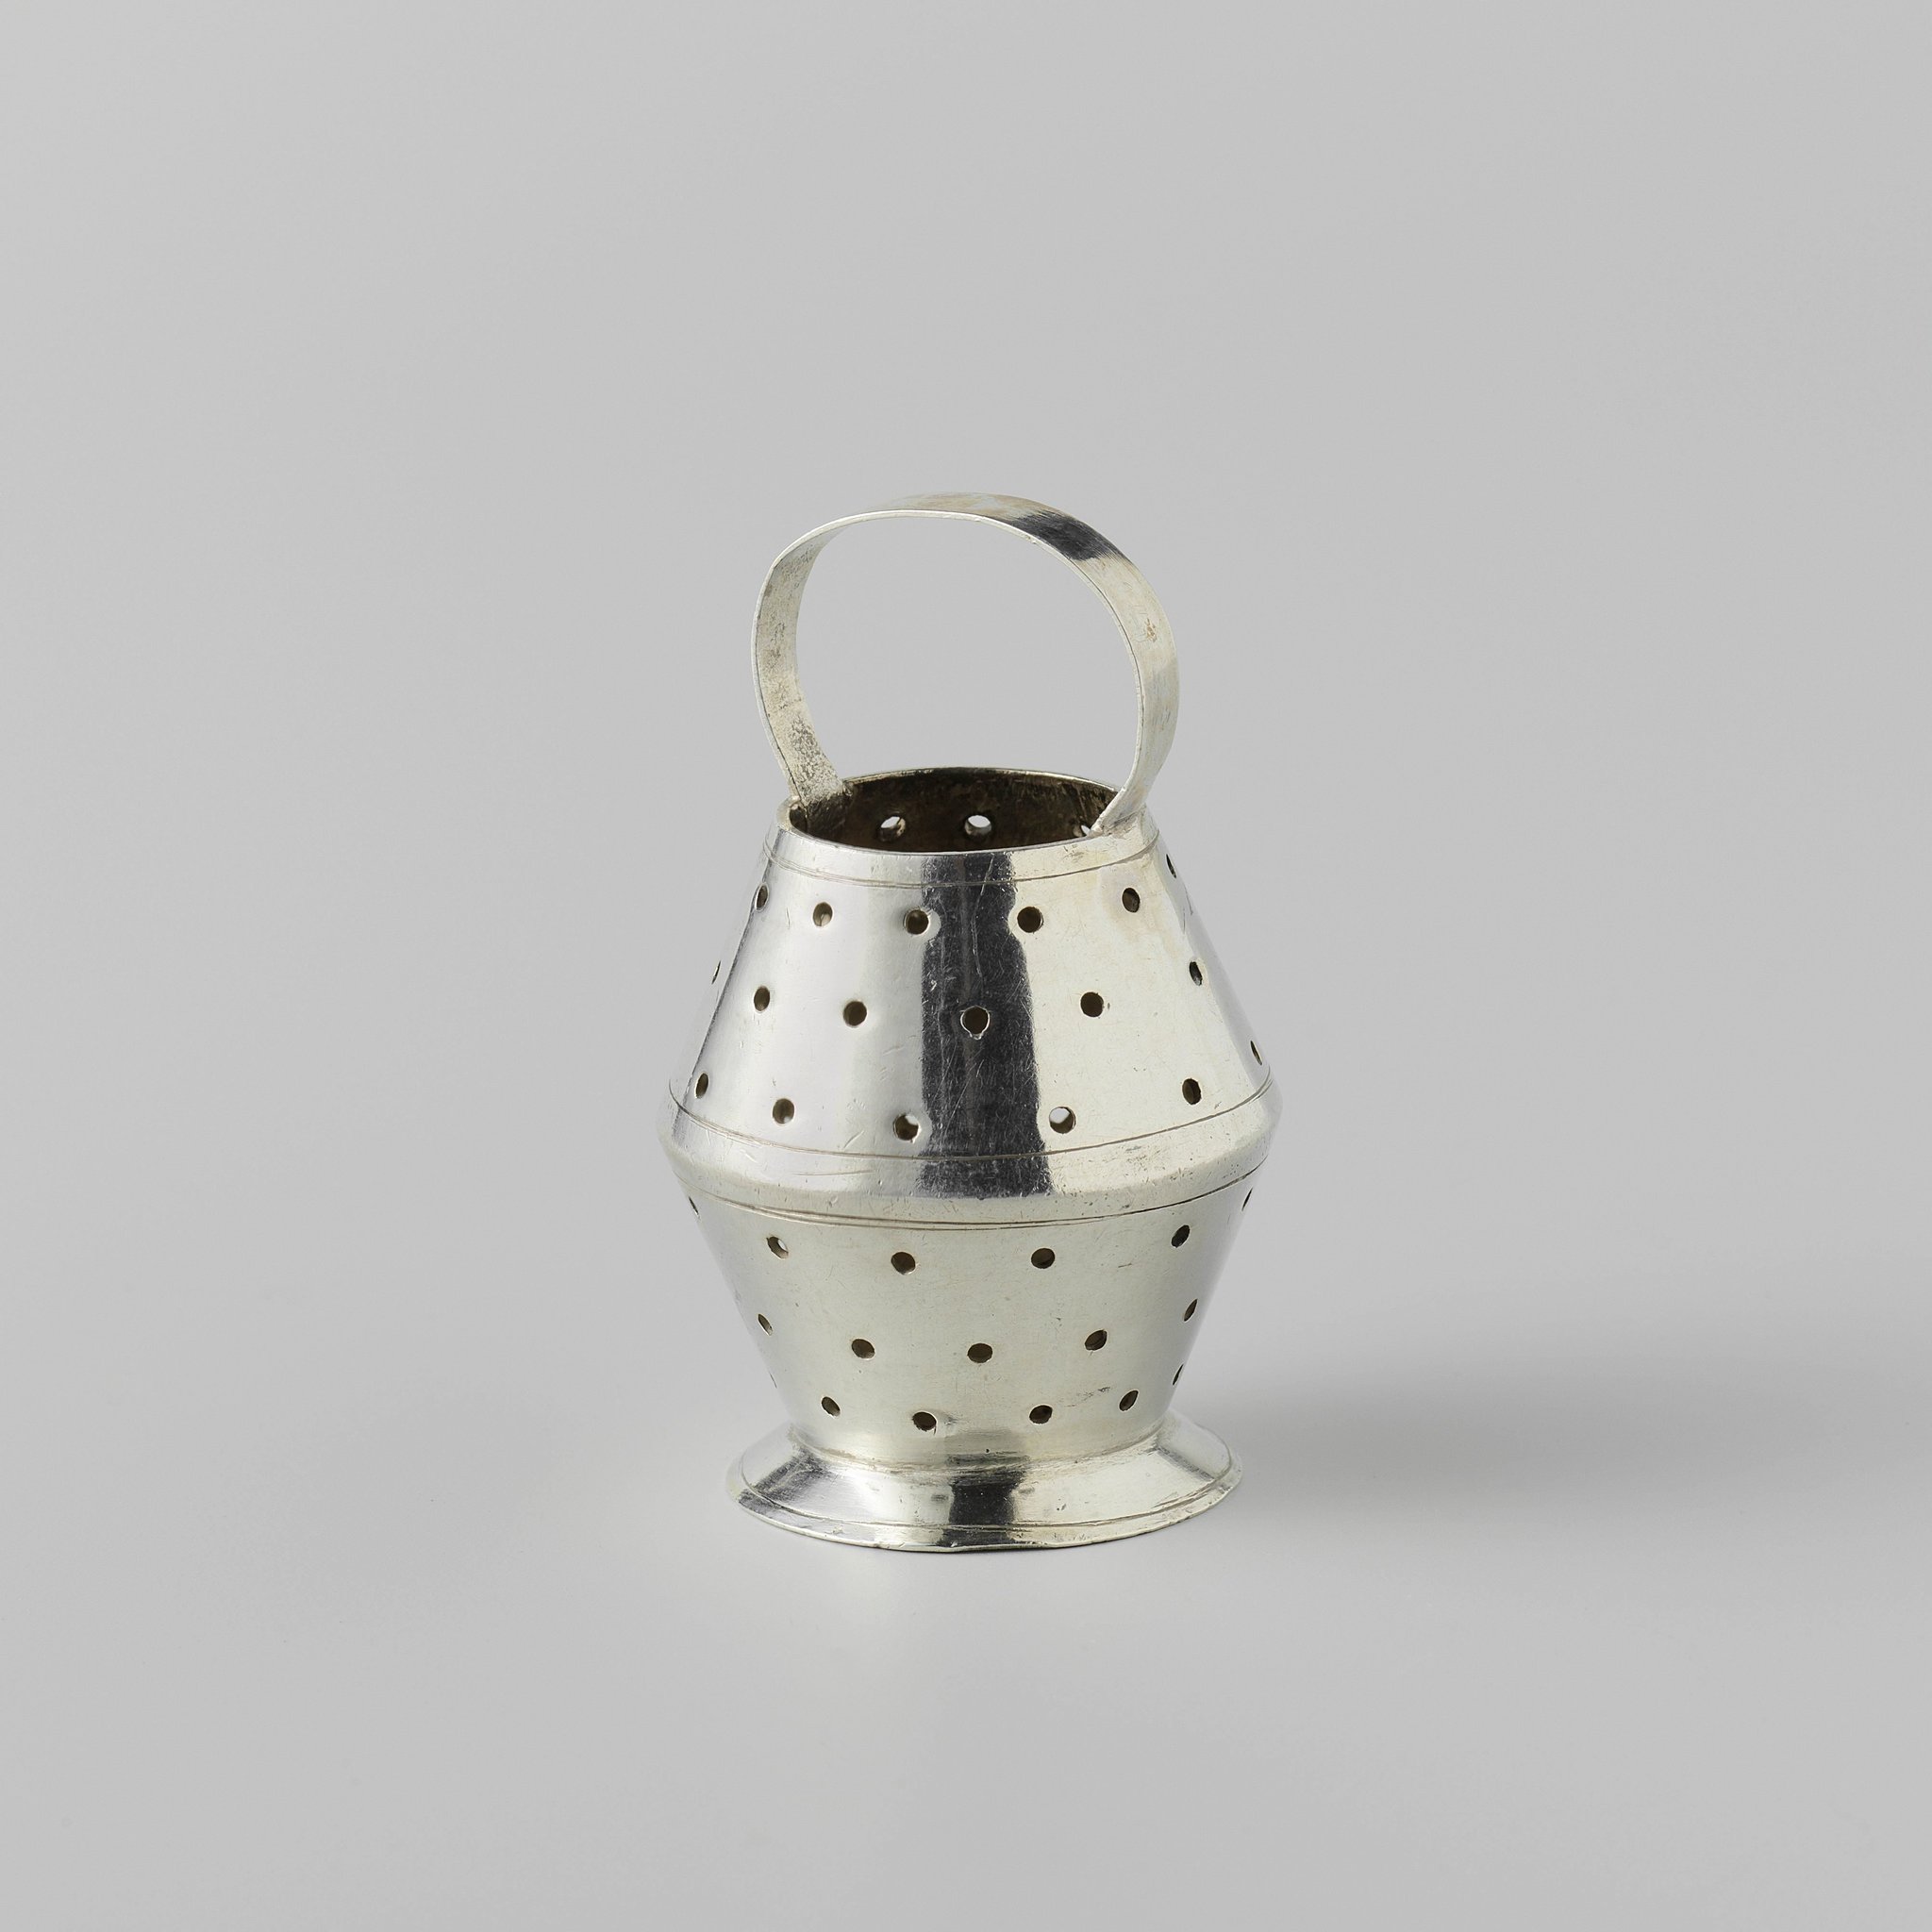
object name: miniature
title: Viskorf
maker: pieter van somerwil (i)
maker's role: silversmith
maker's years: 1706-1753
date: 1734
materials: silver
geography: amsterdam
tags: container of metal: bucket, can, canister, drum, tin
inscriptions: mark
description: Viskorf, dubbelconische emmer op een ronde voet. In de wand zijn zes rijen gaten en gegraveerde lijnen. De emmer heeft een vast hengsel. De emmer is gemerkt: stk.= Amsterdam, jrl.= Z (1734), mt.= Pieter van Somerwil I.